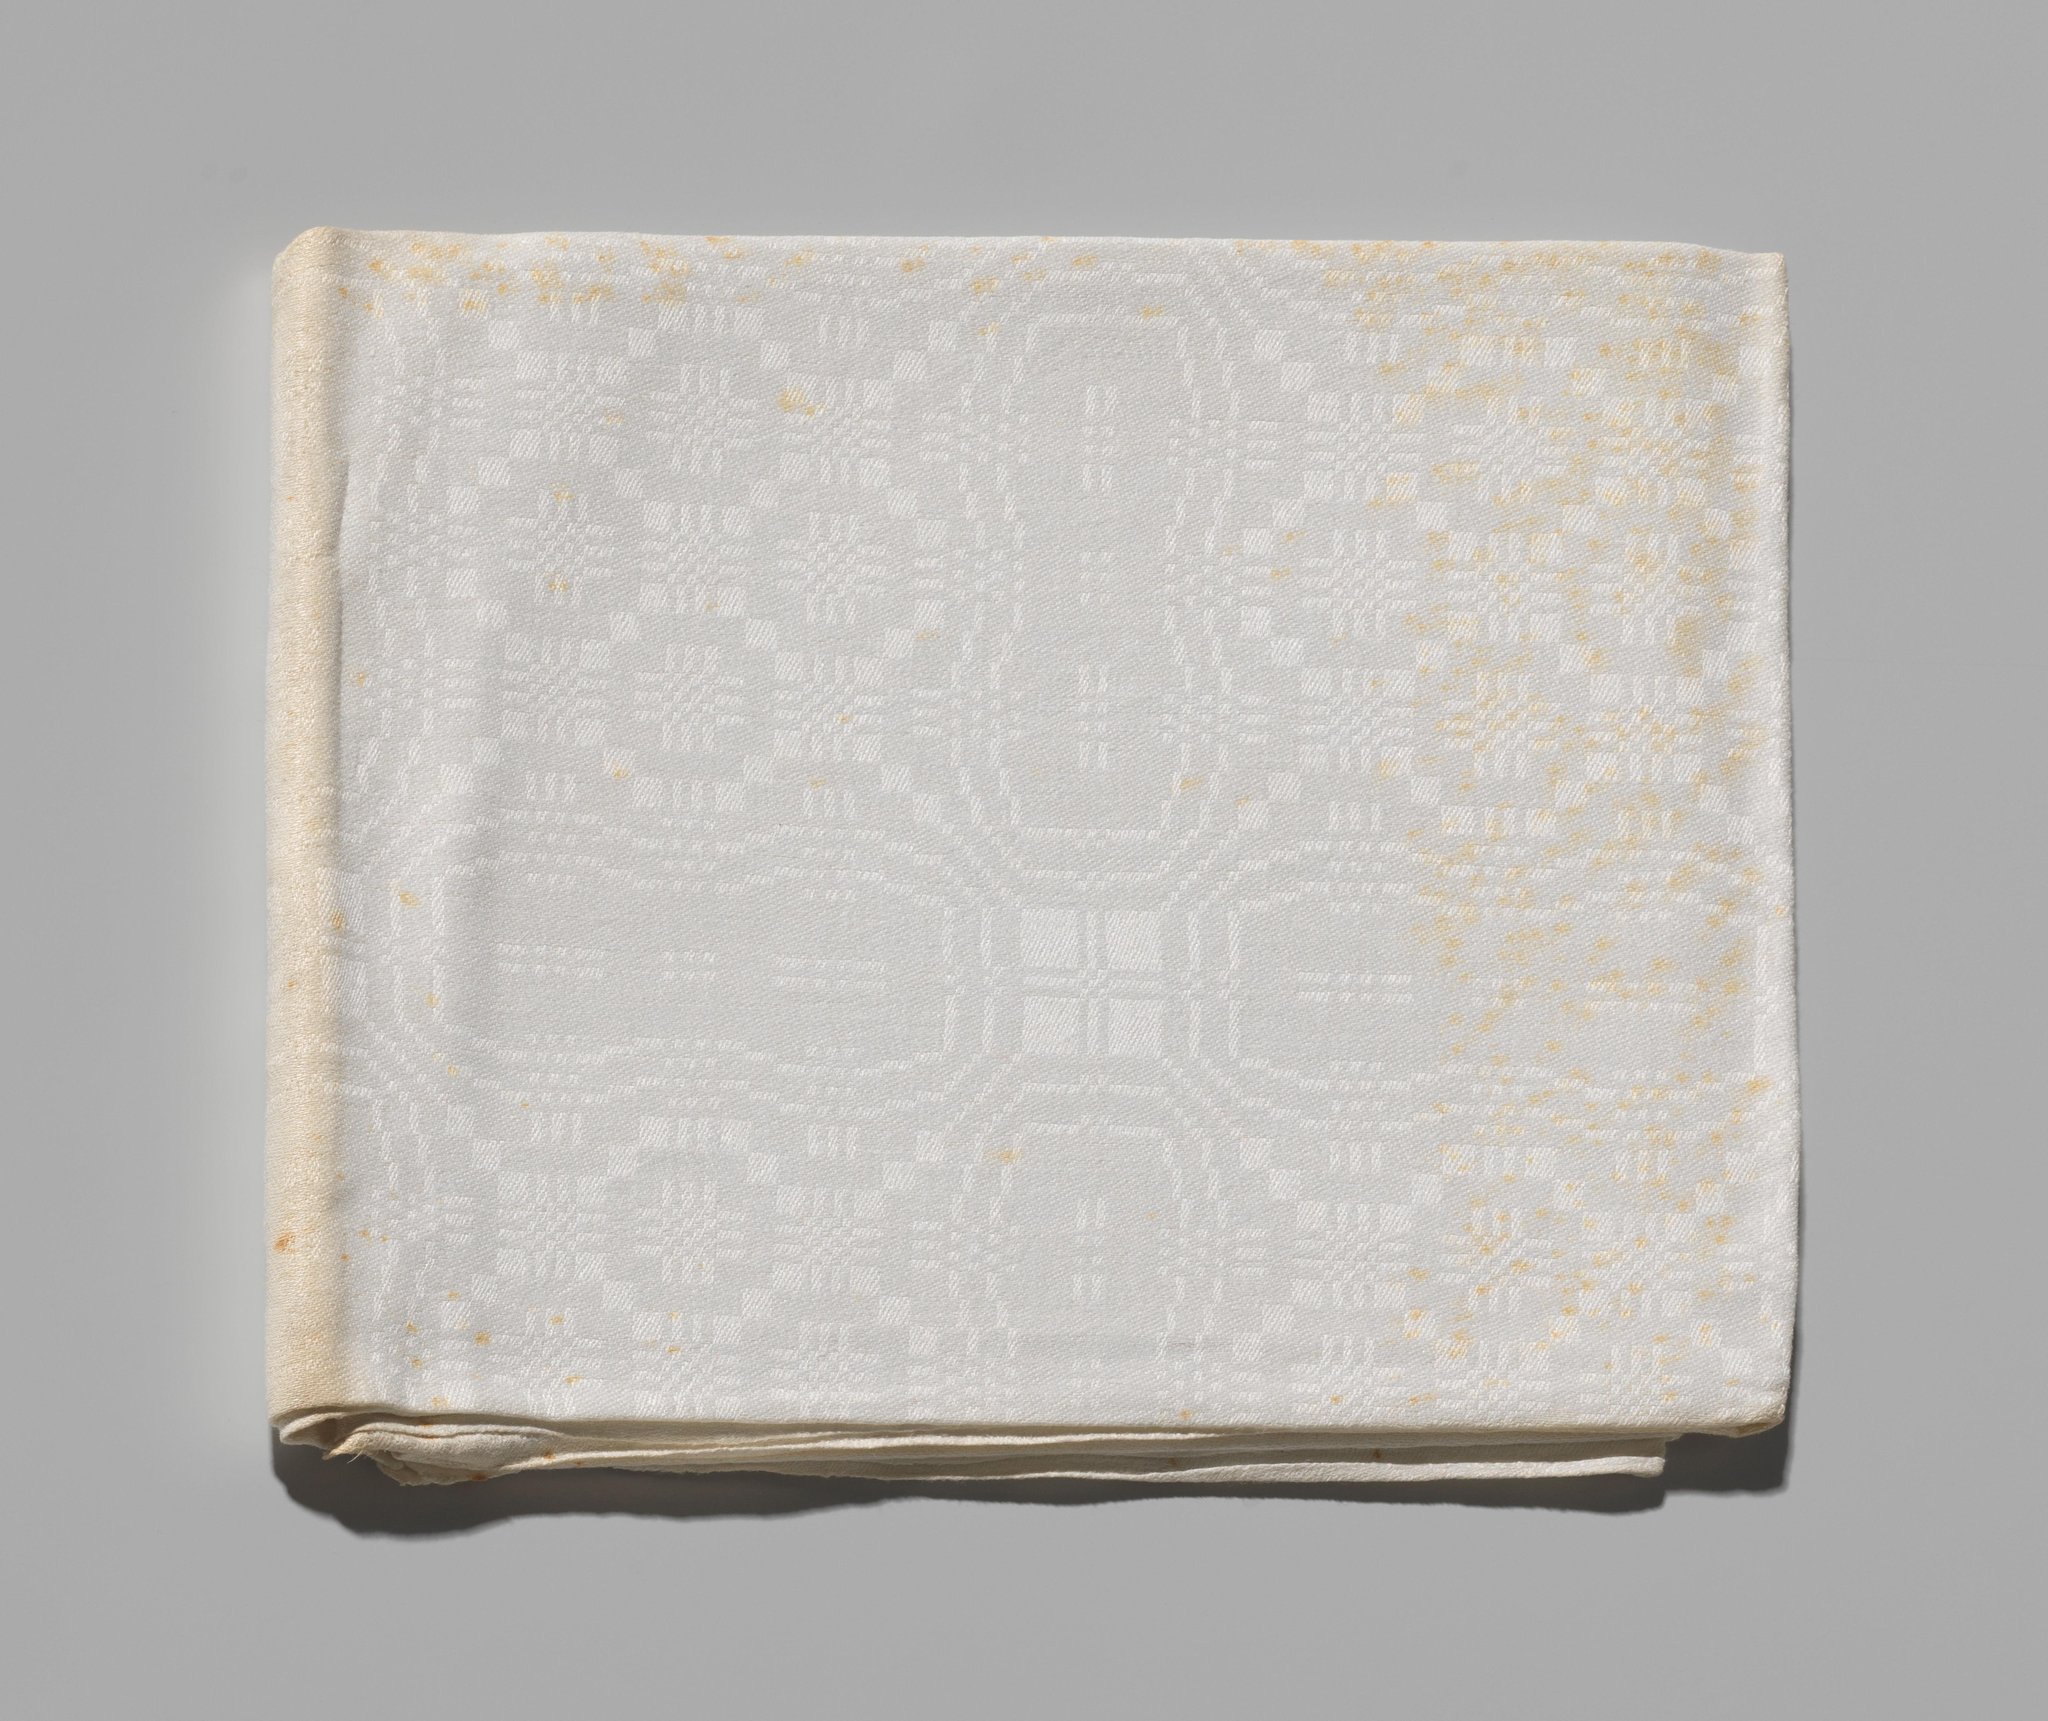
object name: napkin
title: Pellen. Merk geborduurd in de hoek: PP 12.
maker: Anonymous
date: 1800-1900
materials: linen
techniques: weave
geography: netherlands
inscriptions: monogram: ‘PP 12’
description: Servet van linnen pellendamast met randen rondom en in een hoek de geborduurde letters PP 12. Het servet hoort bij vijf servetten (BK-1980-161-A t/m BK-1980-161-F) en een tafellaken (BK-1980-160).